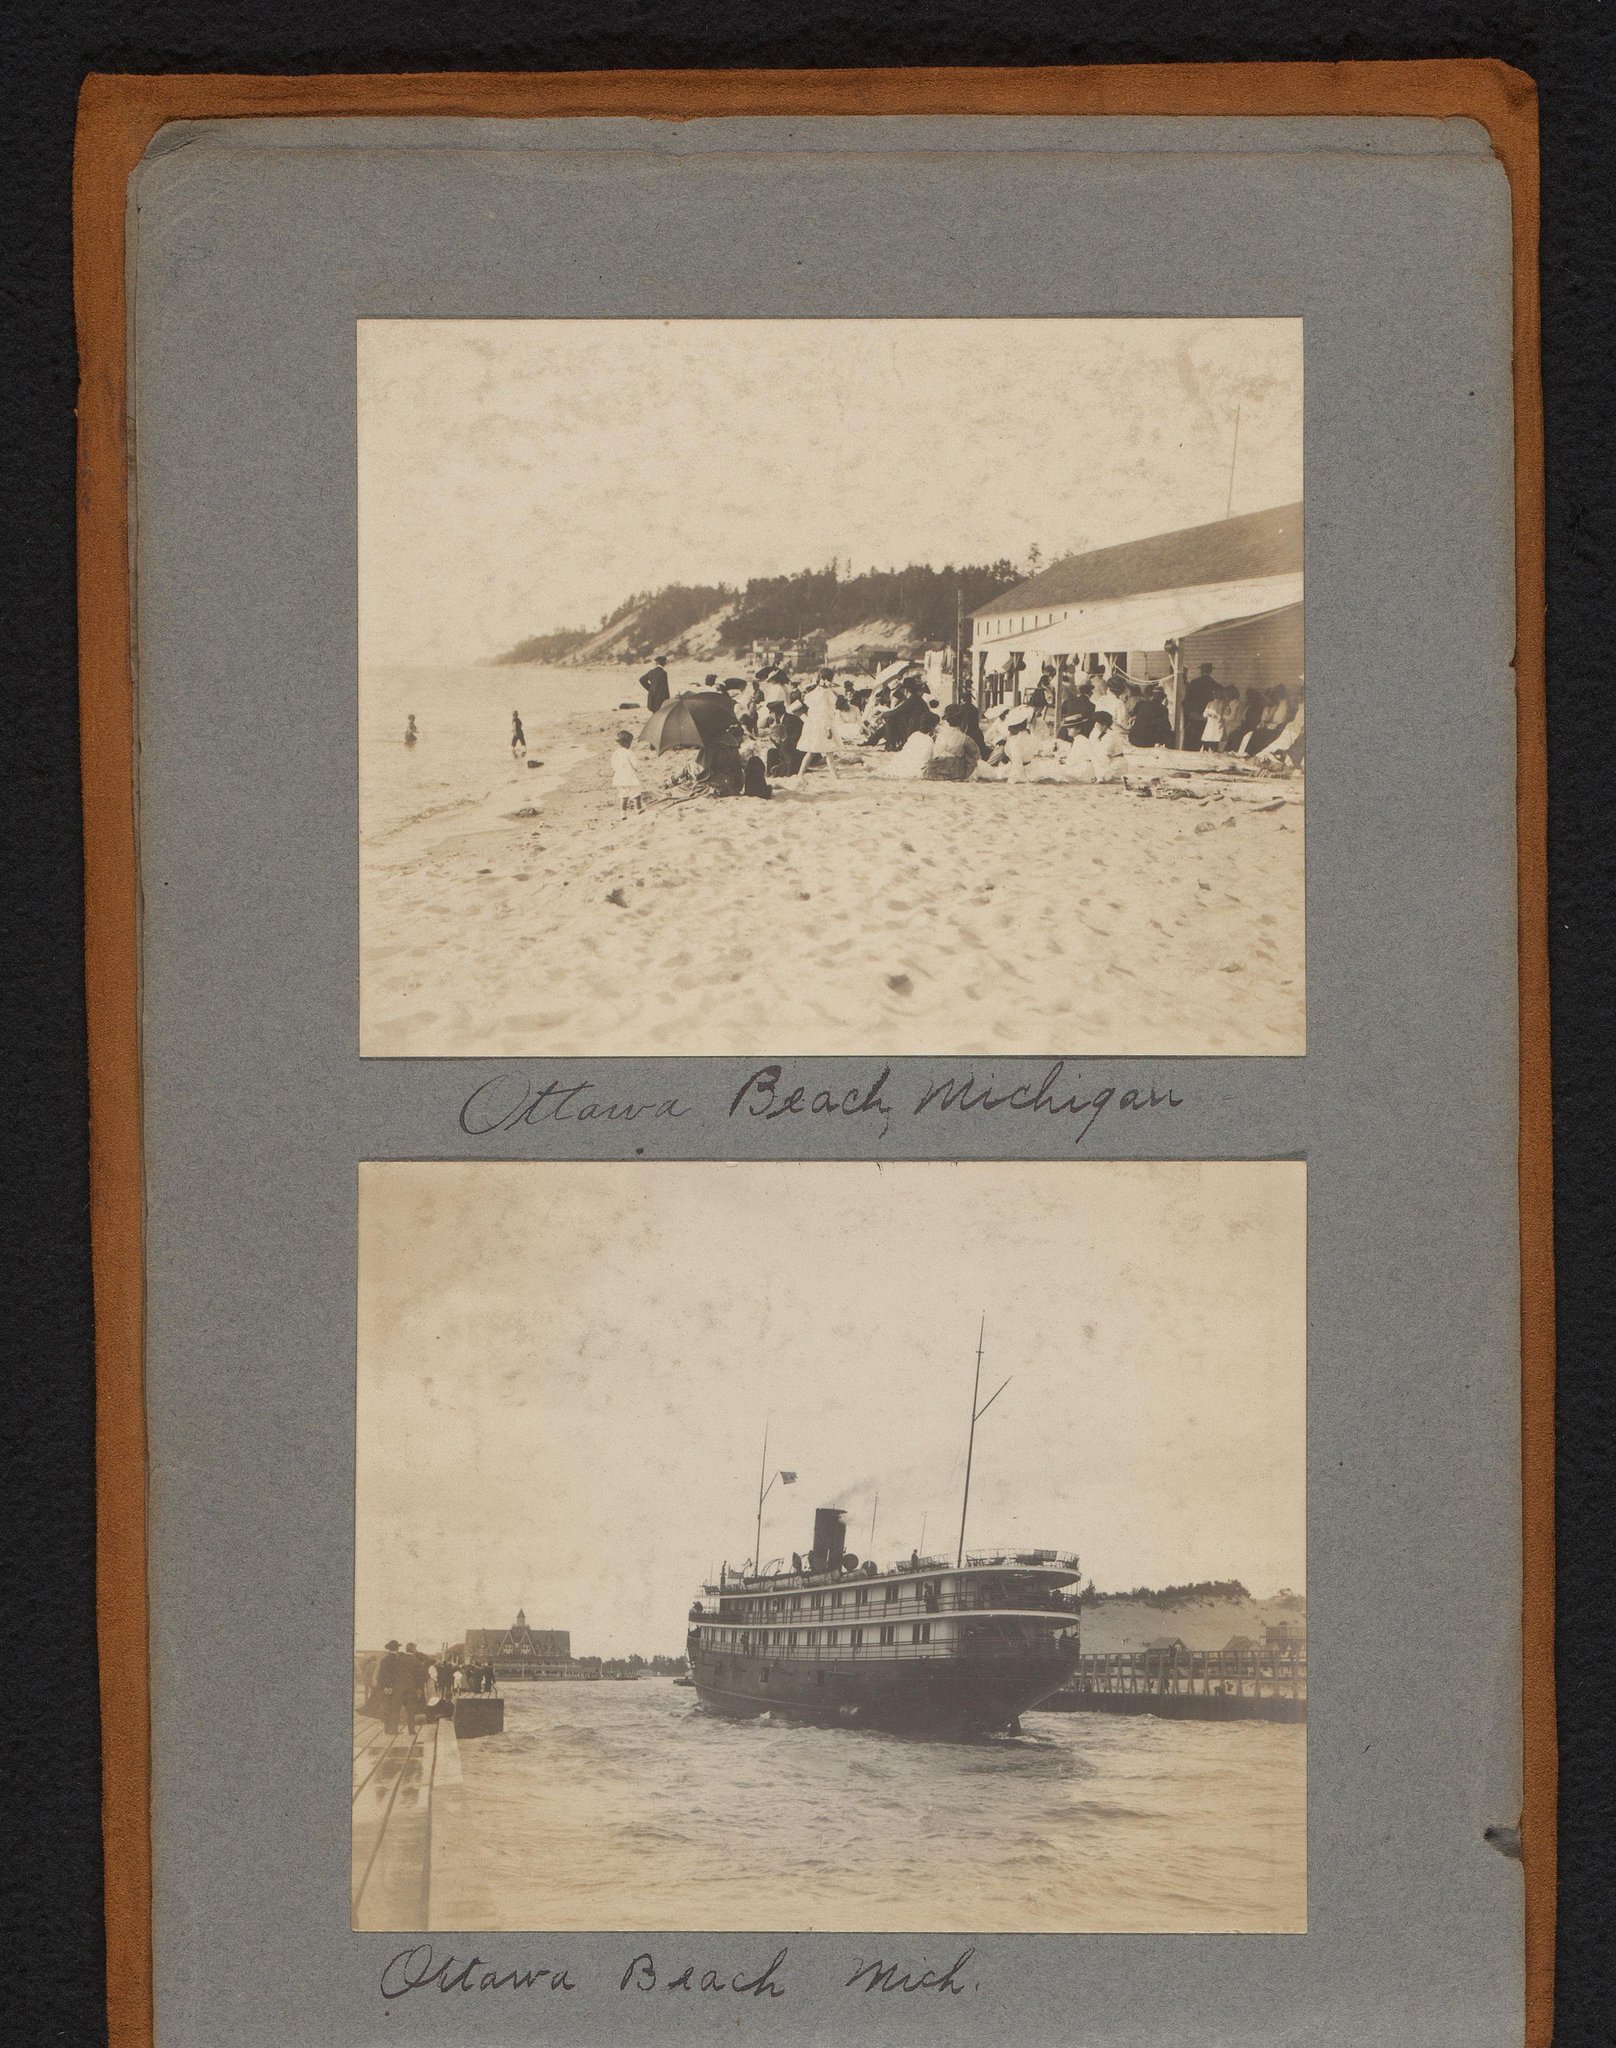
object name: photograph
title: Ottawa Beach, Michigan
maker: jan van der mey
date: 1902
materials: paper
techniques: gelatin silver print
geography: michigan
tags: beach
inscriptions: inscription: ‘Ottawa Beach, Michigan/ Ottawa Beach Mich.’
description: Deze foto's maken deel uit van een album.